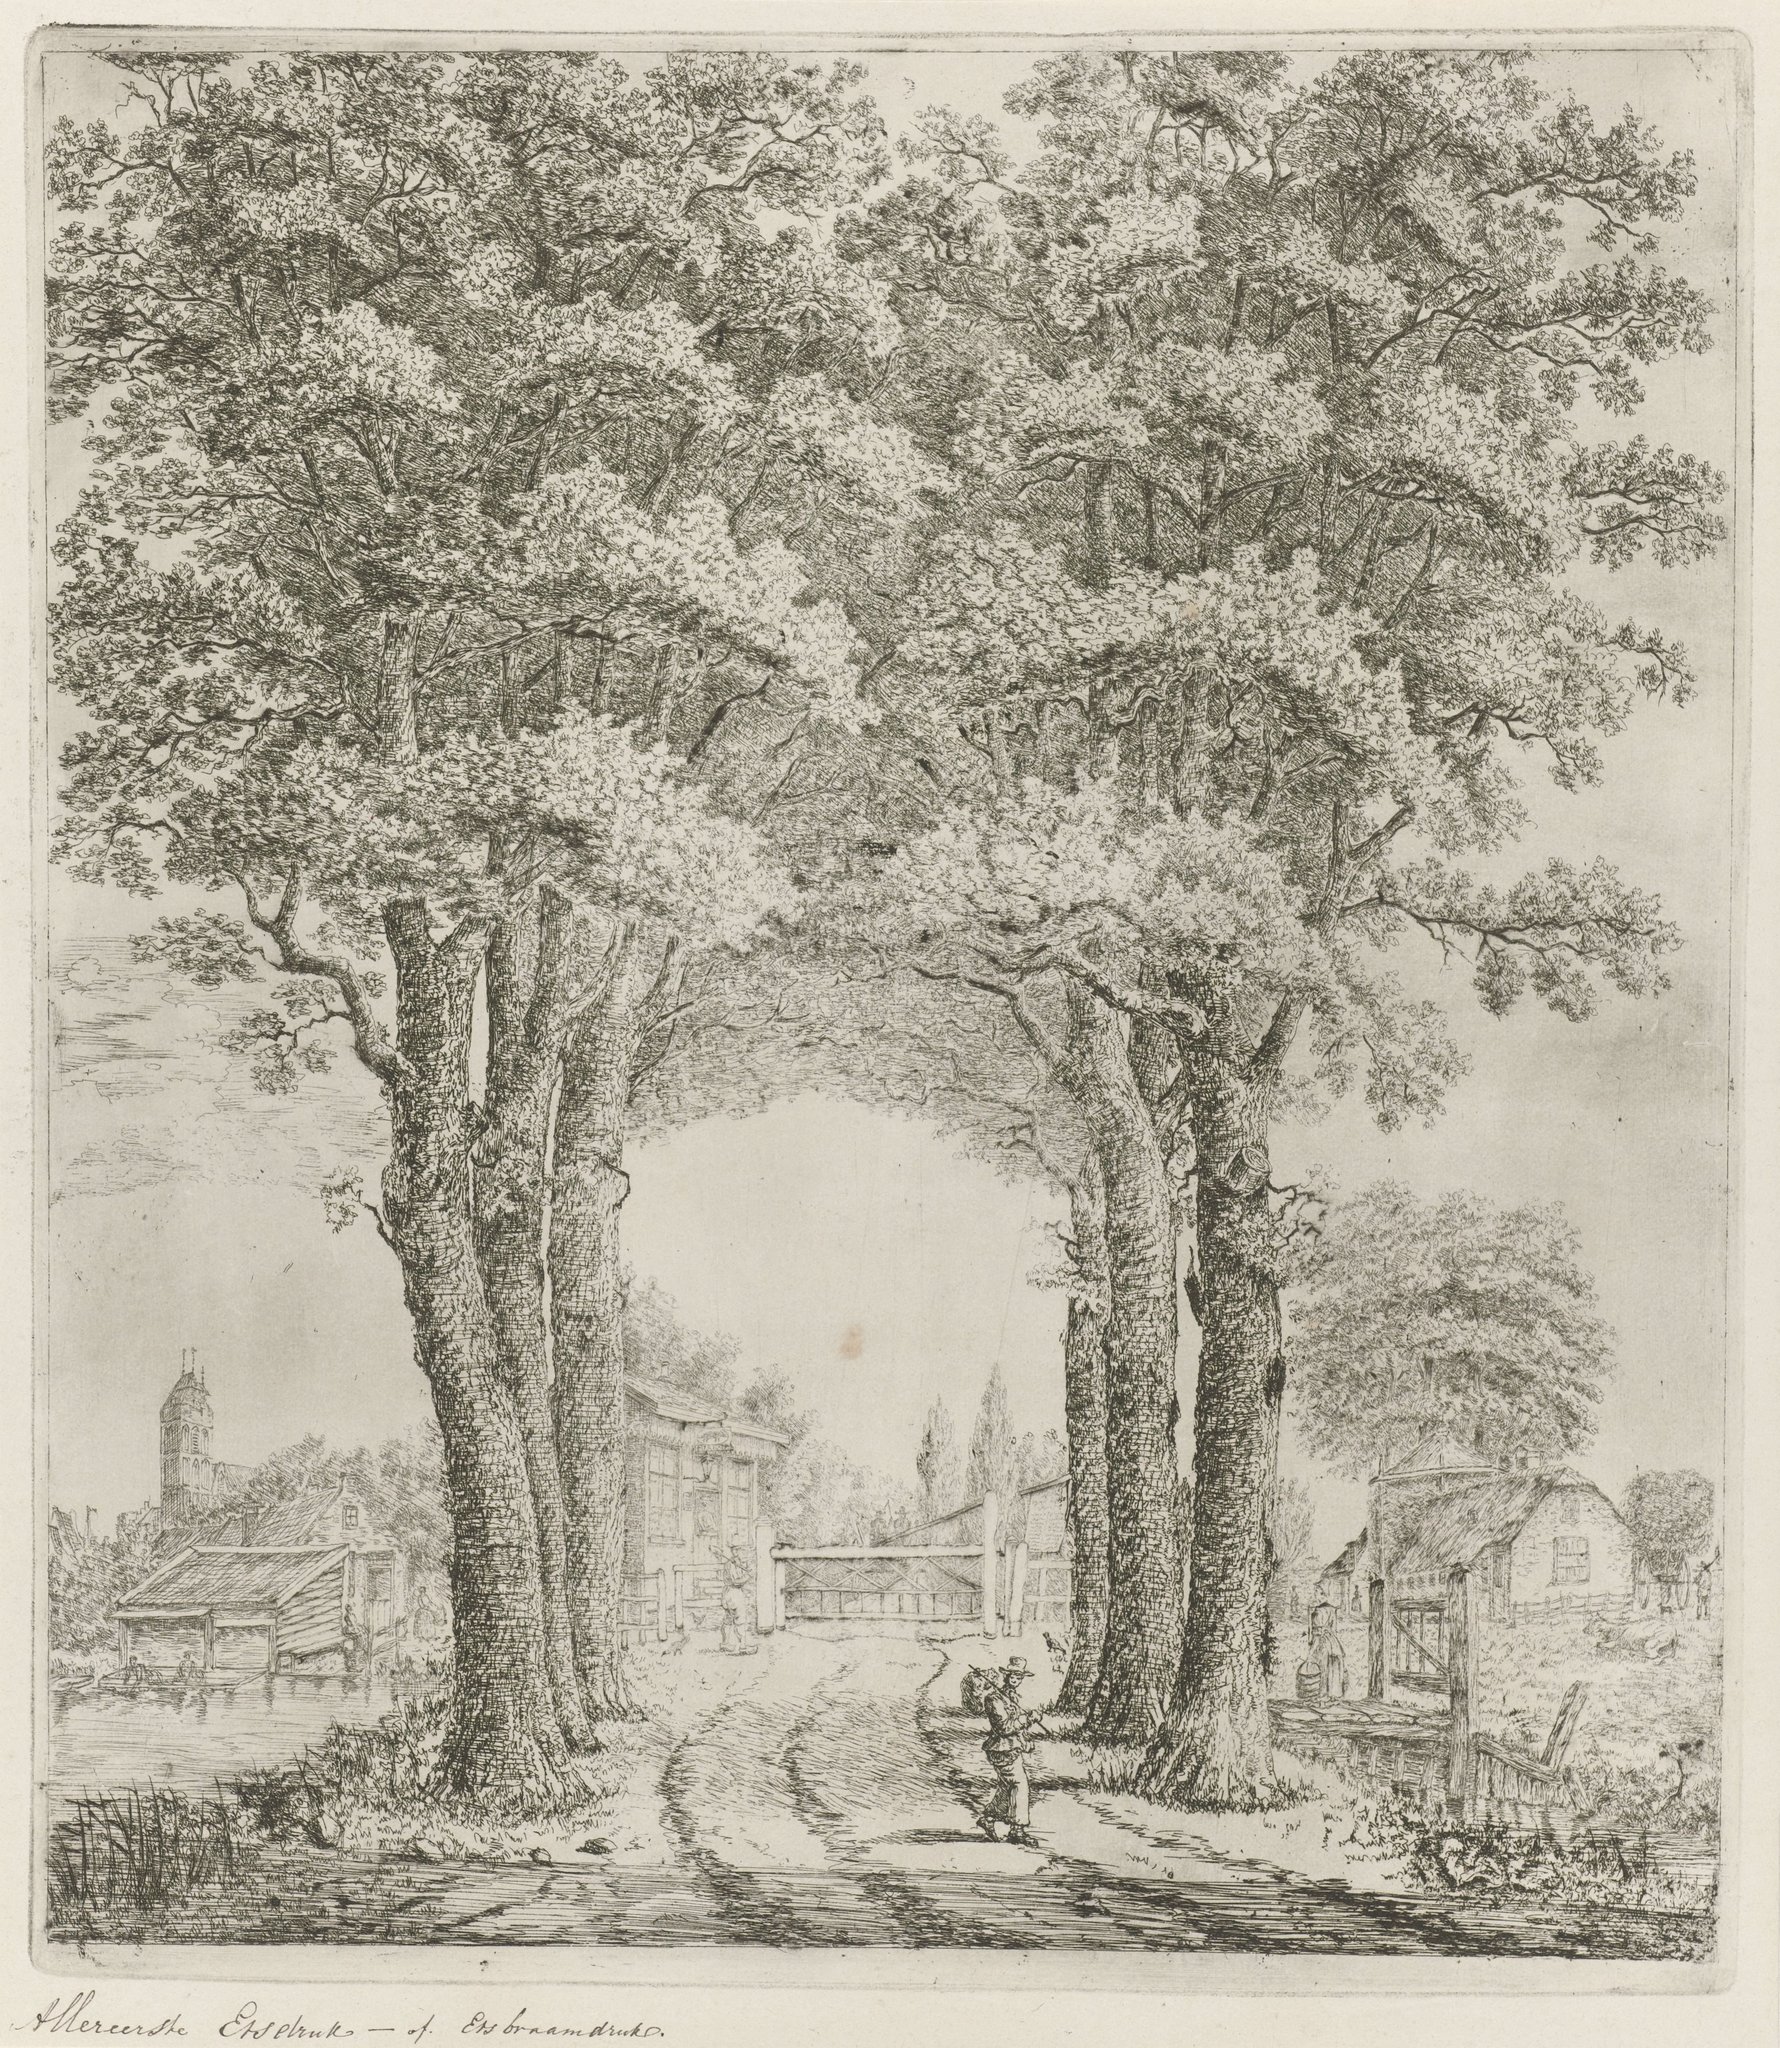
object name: print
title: Groep bomen bij Oudewater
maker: eberhard cornelis rahms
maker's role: print maker, publisher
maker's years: 1823-1907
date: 1808-1860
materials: paper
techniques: drypoint, etching, intaglio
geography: oudewater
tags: church (exterior), groups of trees, toll gate, 'en route', traveller under way, farm or solitary house in landscape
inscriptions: inscription: ‘Koper - N 12 - Geetst Aug 1860 / Eene Groep opgaande boomen / of / De Tolboom aan het varkje by Oudewater / vervaardigd en samengesteld uit het Schetsboek / [...] natuur geteekend [...] Aug 1860’, collector's mark: Lugt 2228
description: Gezicht op een groep aan een weg gelegen bomen bij Oudewater. Achter de bomen het tolhek en de tolgaarders woning. Op de voorgrond enkele figuren en rechts een boerenhoeve. Links op de achtergrond de toren van de Sint Michaëlskerk.